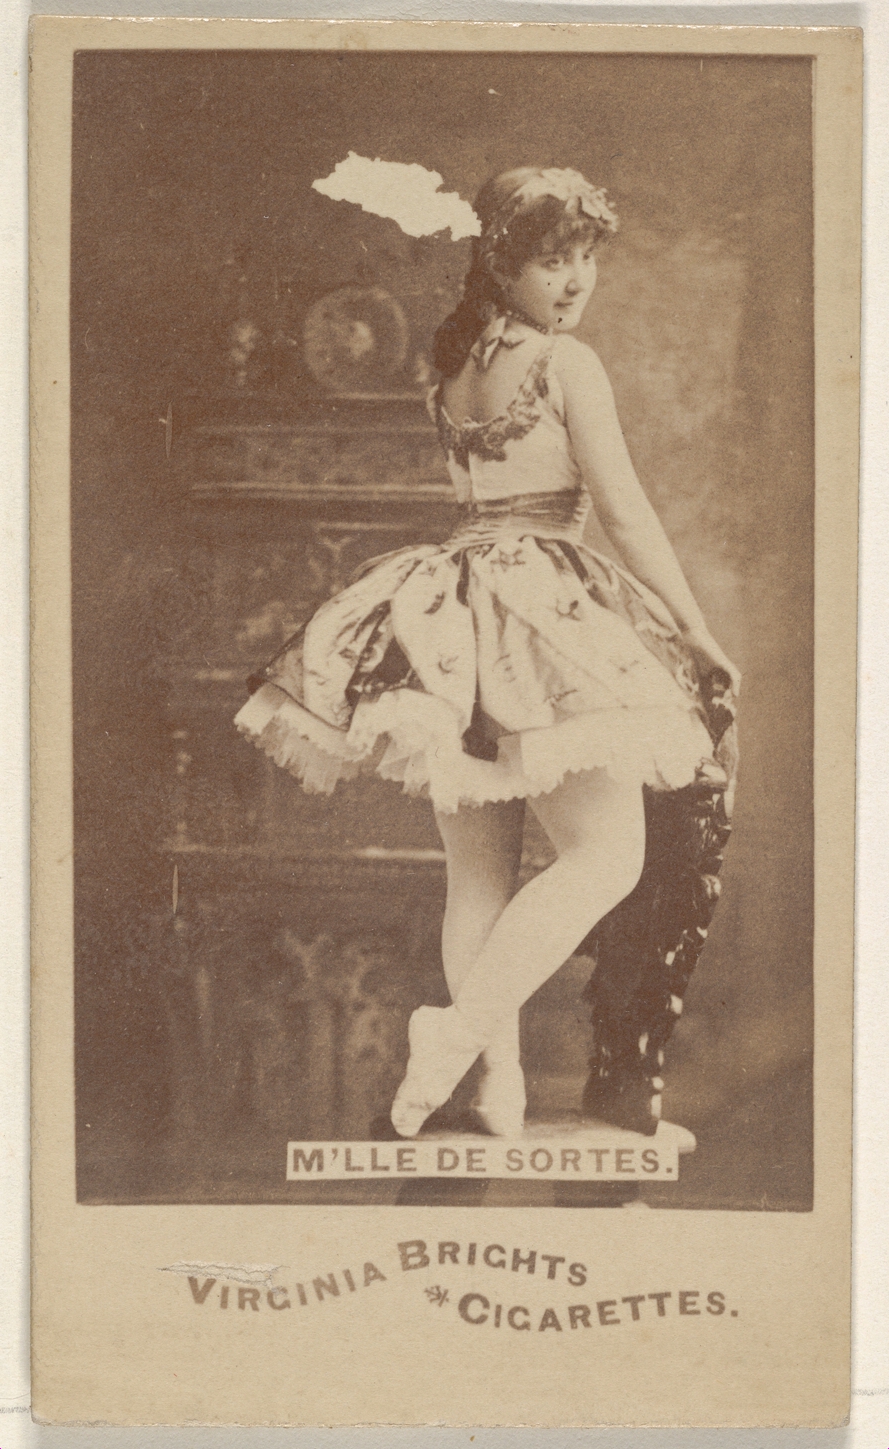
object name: photograph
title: M'lle de Sortes, from the Actors and Actresses series (N45, Type 6) for Virginia Brights Cigarettes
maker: allen & ginter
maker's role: publisher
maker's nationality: american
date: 1888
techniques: albumen silver print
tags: portraits,women,actresses